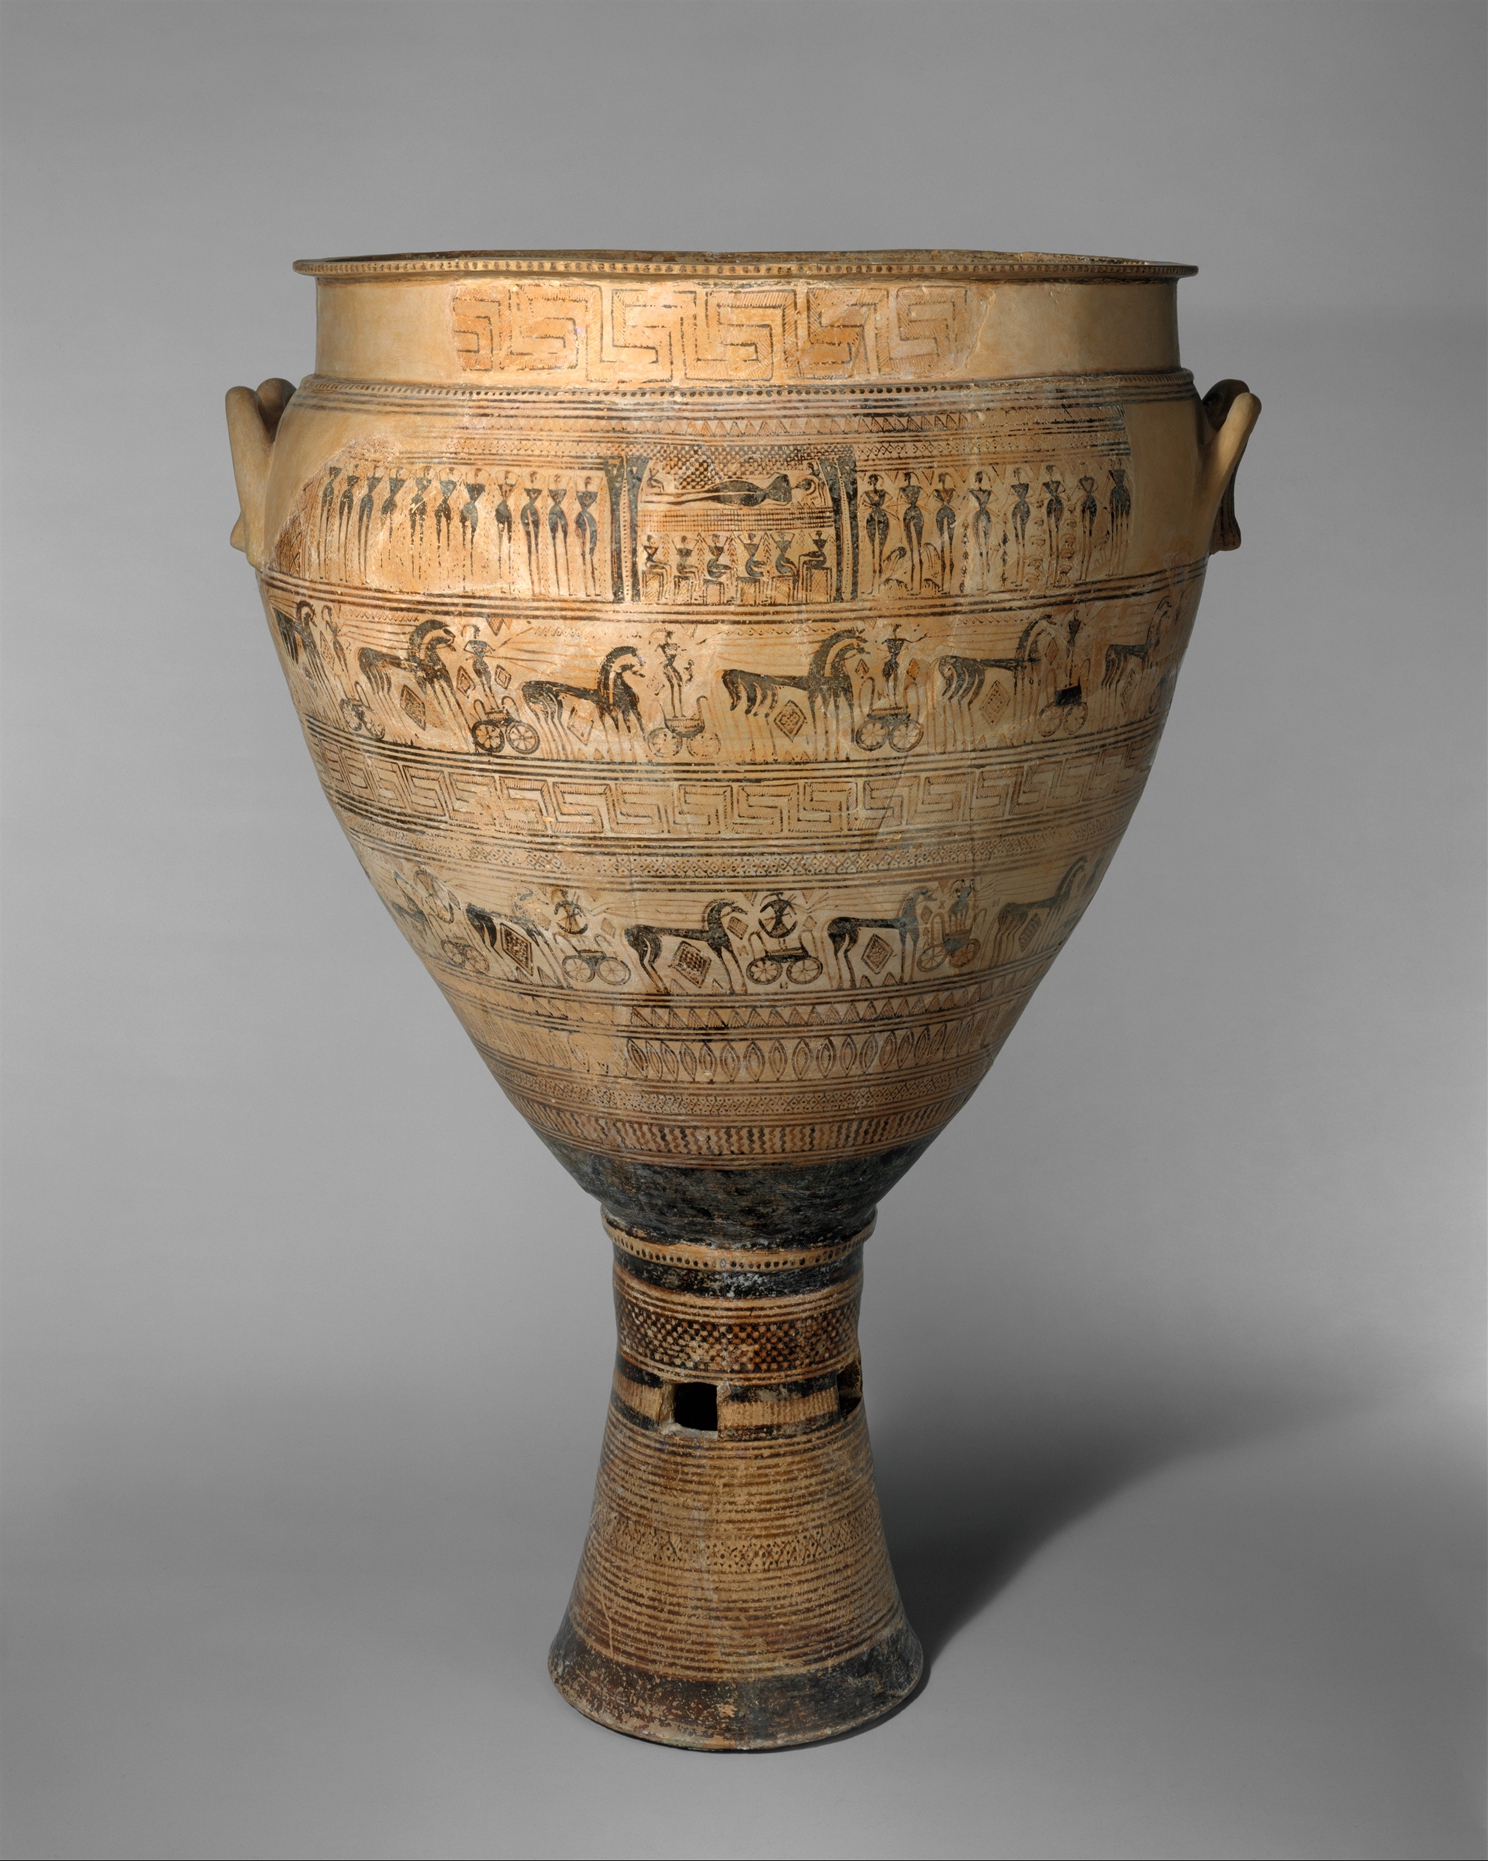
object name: krater, dipylon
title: Terracotta krater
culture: greek, attic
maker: trachones workshop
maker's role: artist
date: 725 BCE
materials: terracotta